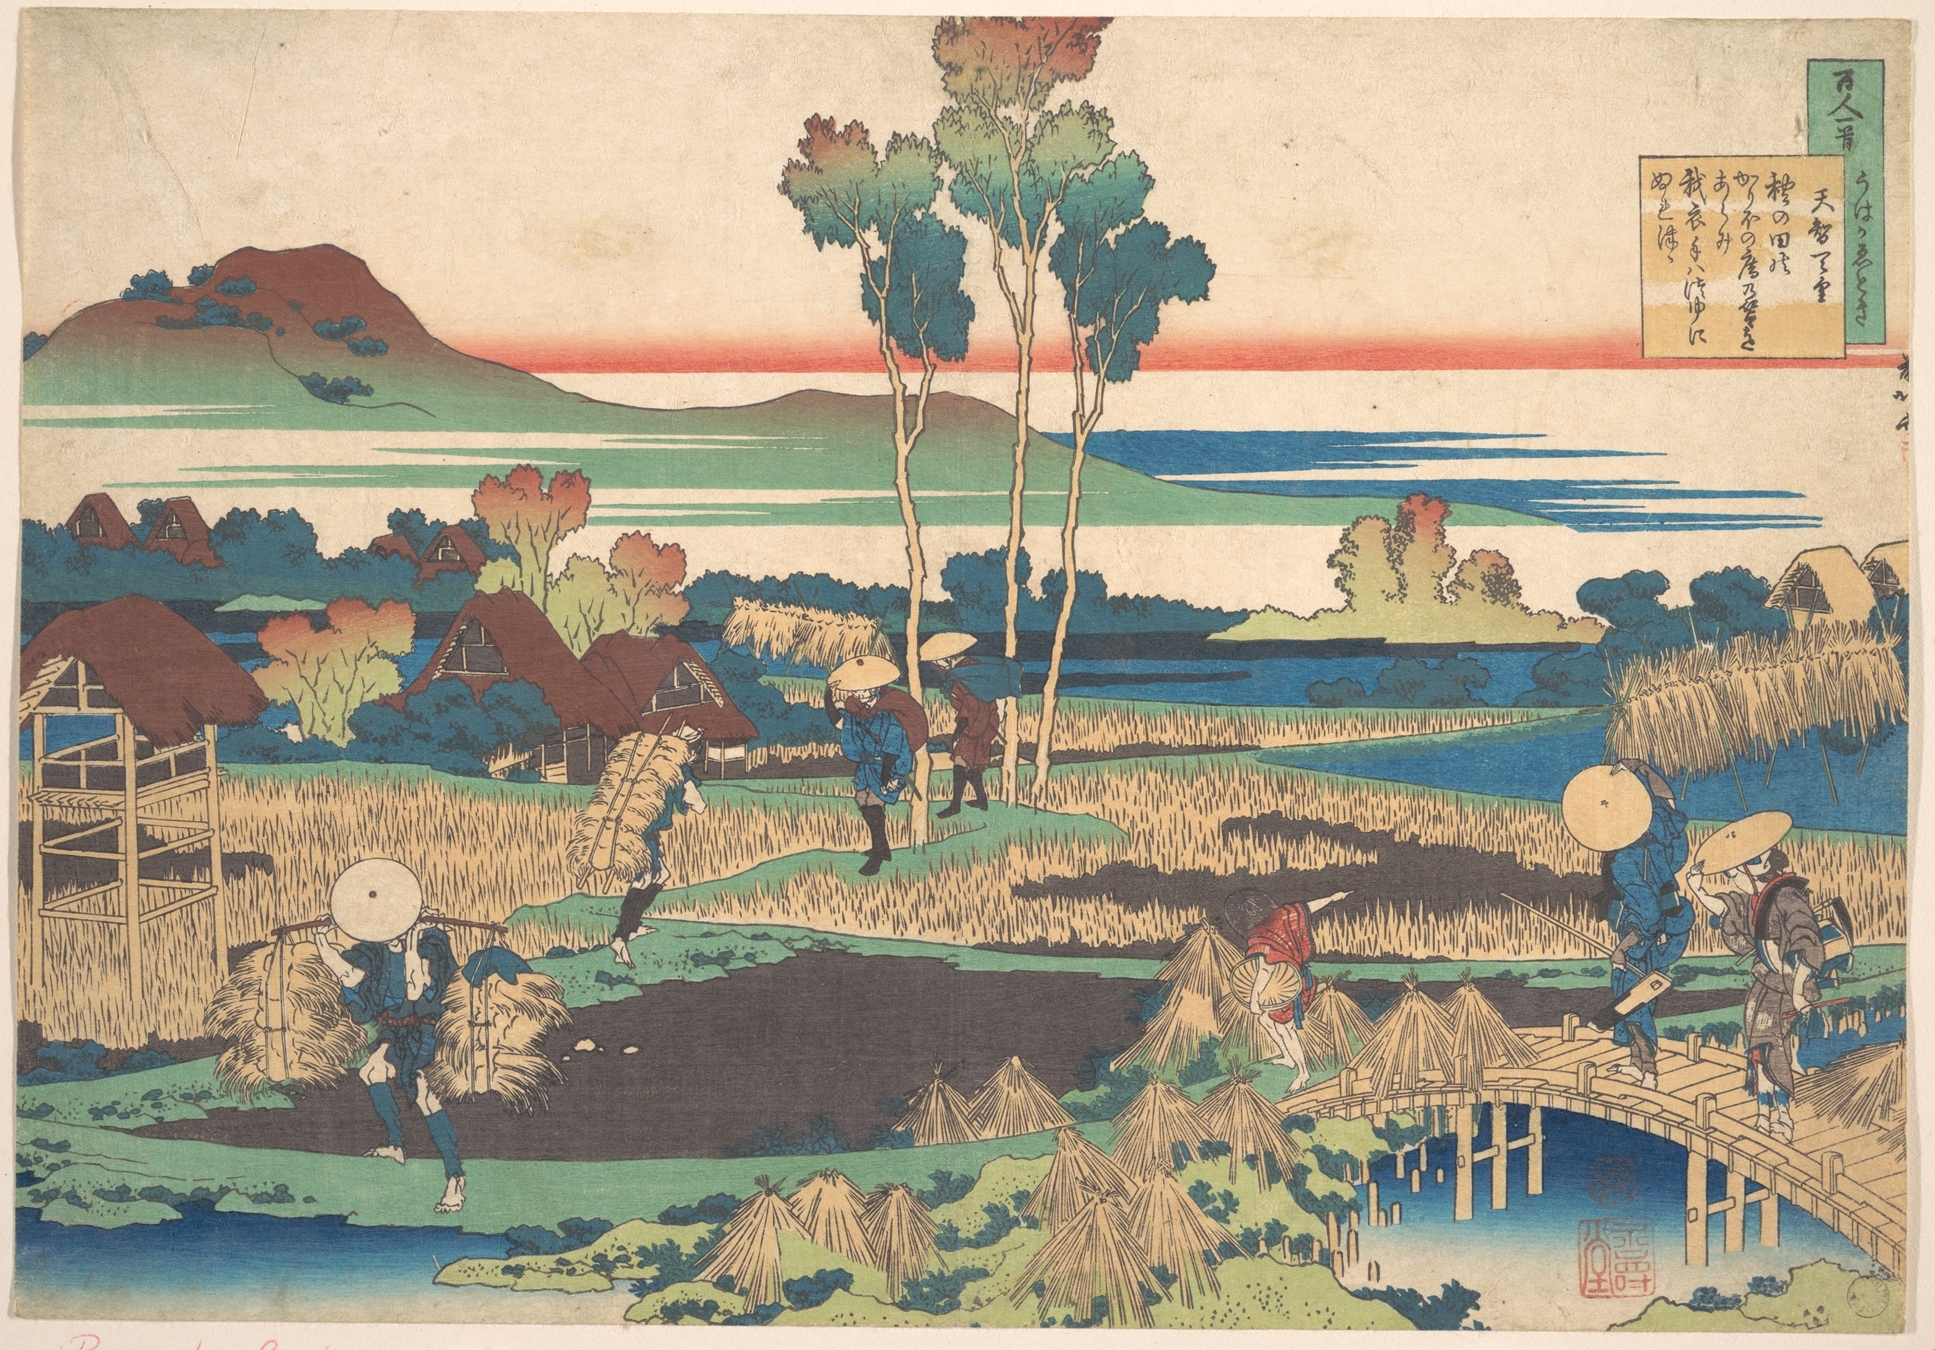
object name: woodblock print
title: Poem by Tenchi Tennō, from the series One Hundred Poems Explained by the Nurse (Hyakunin isshu uba ga etoki)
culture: japanese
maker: katsushika hokusai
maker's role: artist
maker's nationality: japanese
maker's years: 1760-1849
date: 1839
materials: ink, paper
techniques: woodblock print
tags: human figures,bridges,hills,trees,working